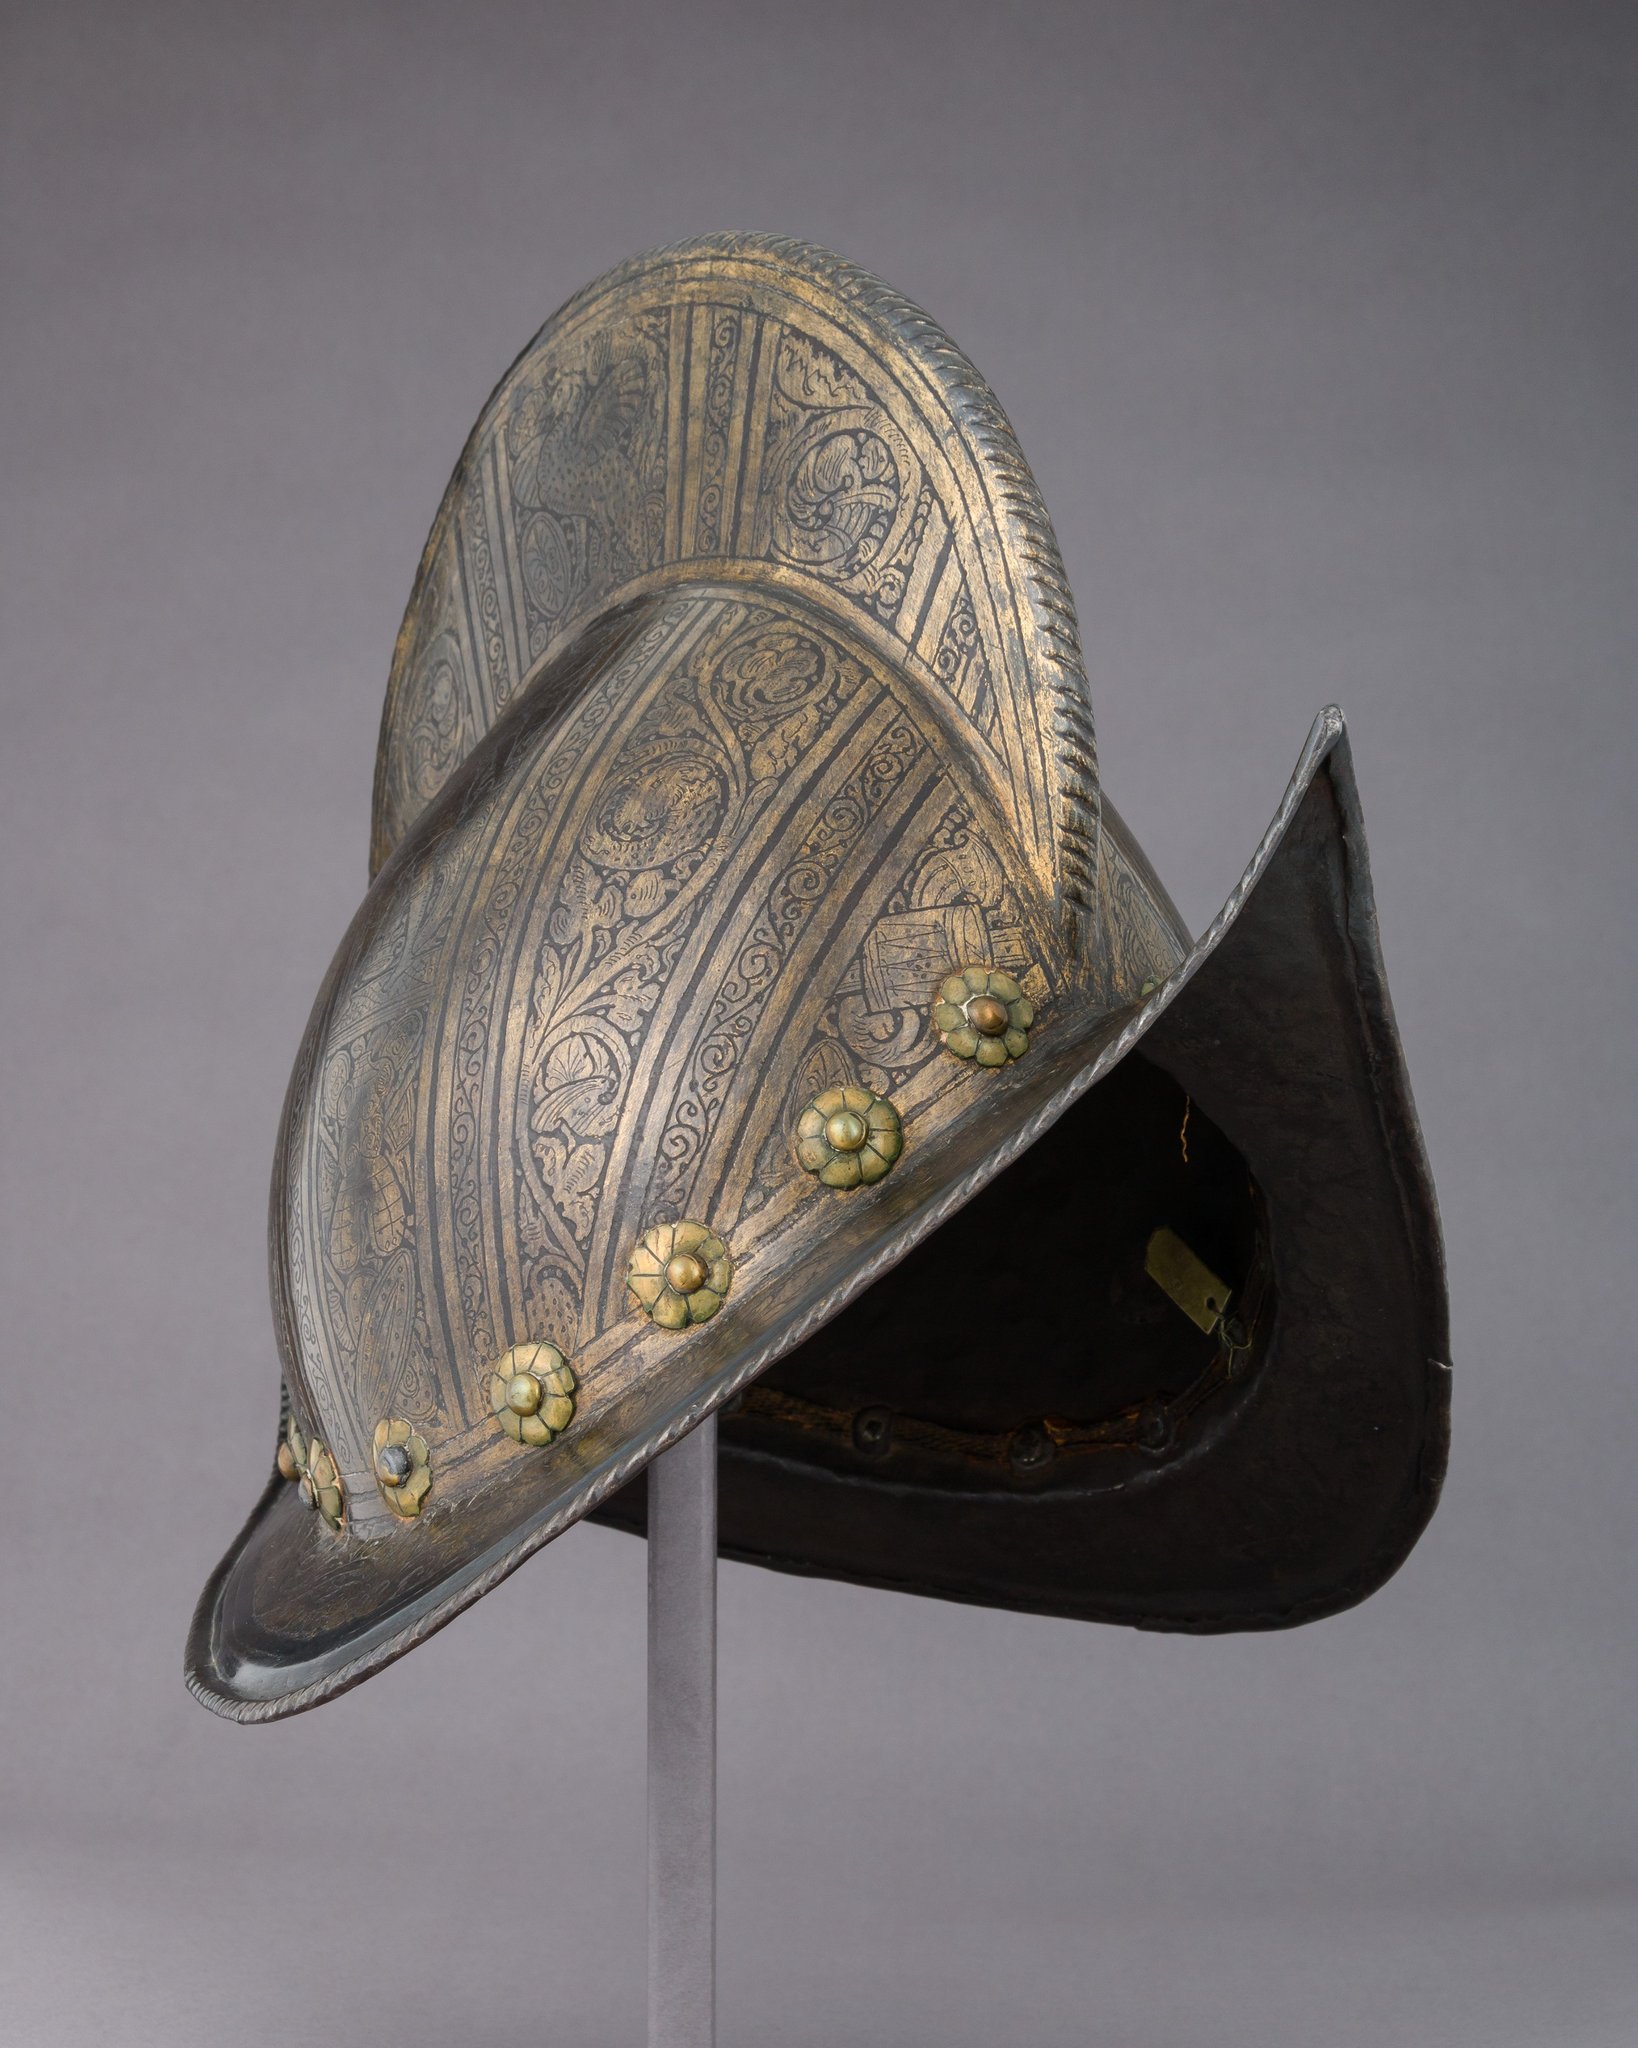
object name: morion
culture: italian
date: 1575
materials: brass, gold, steel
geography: italy